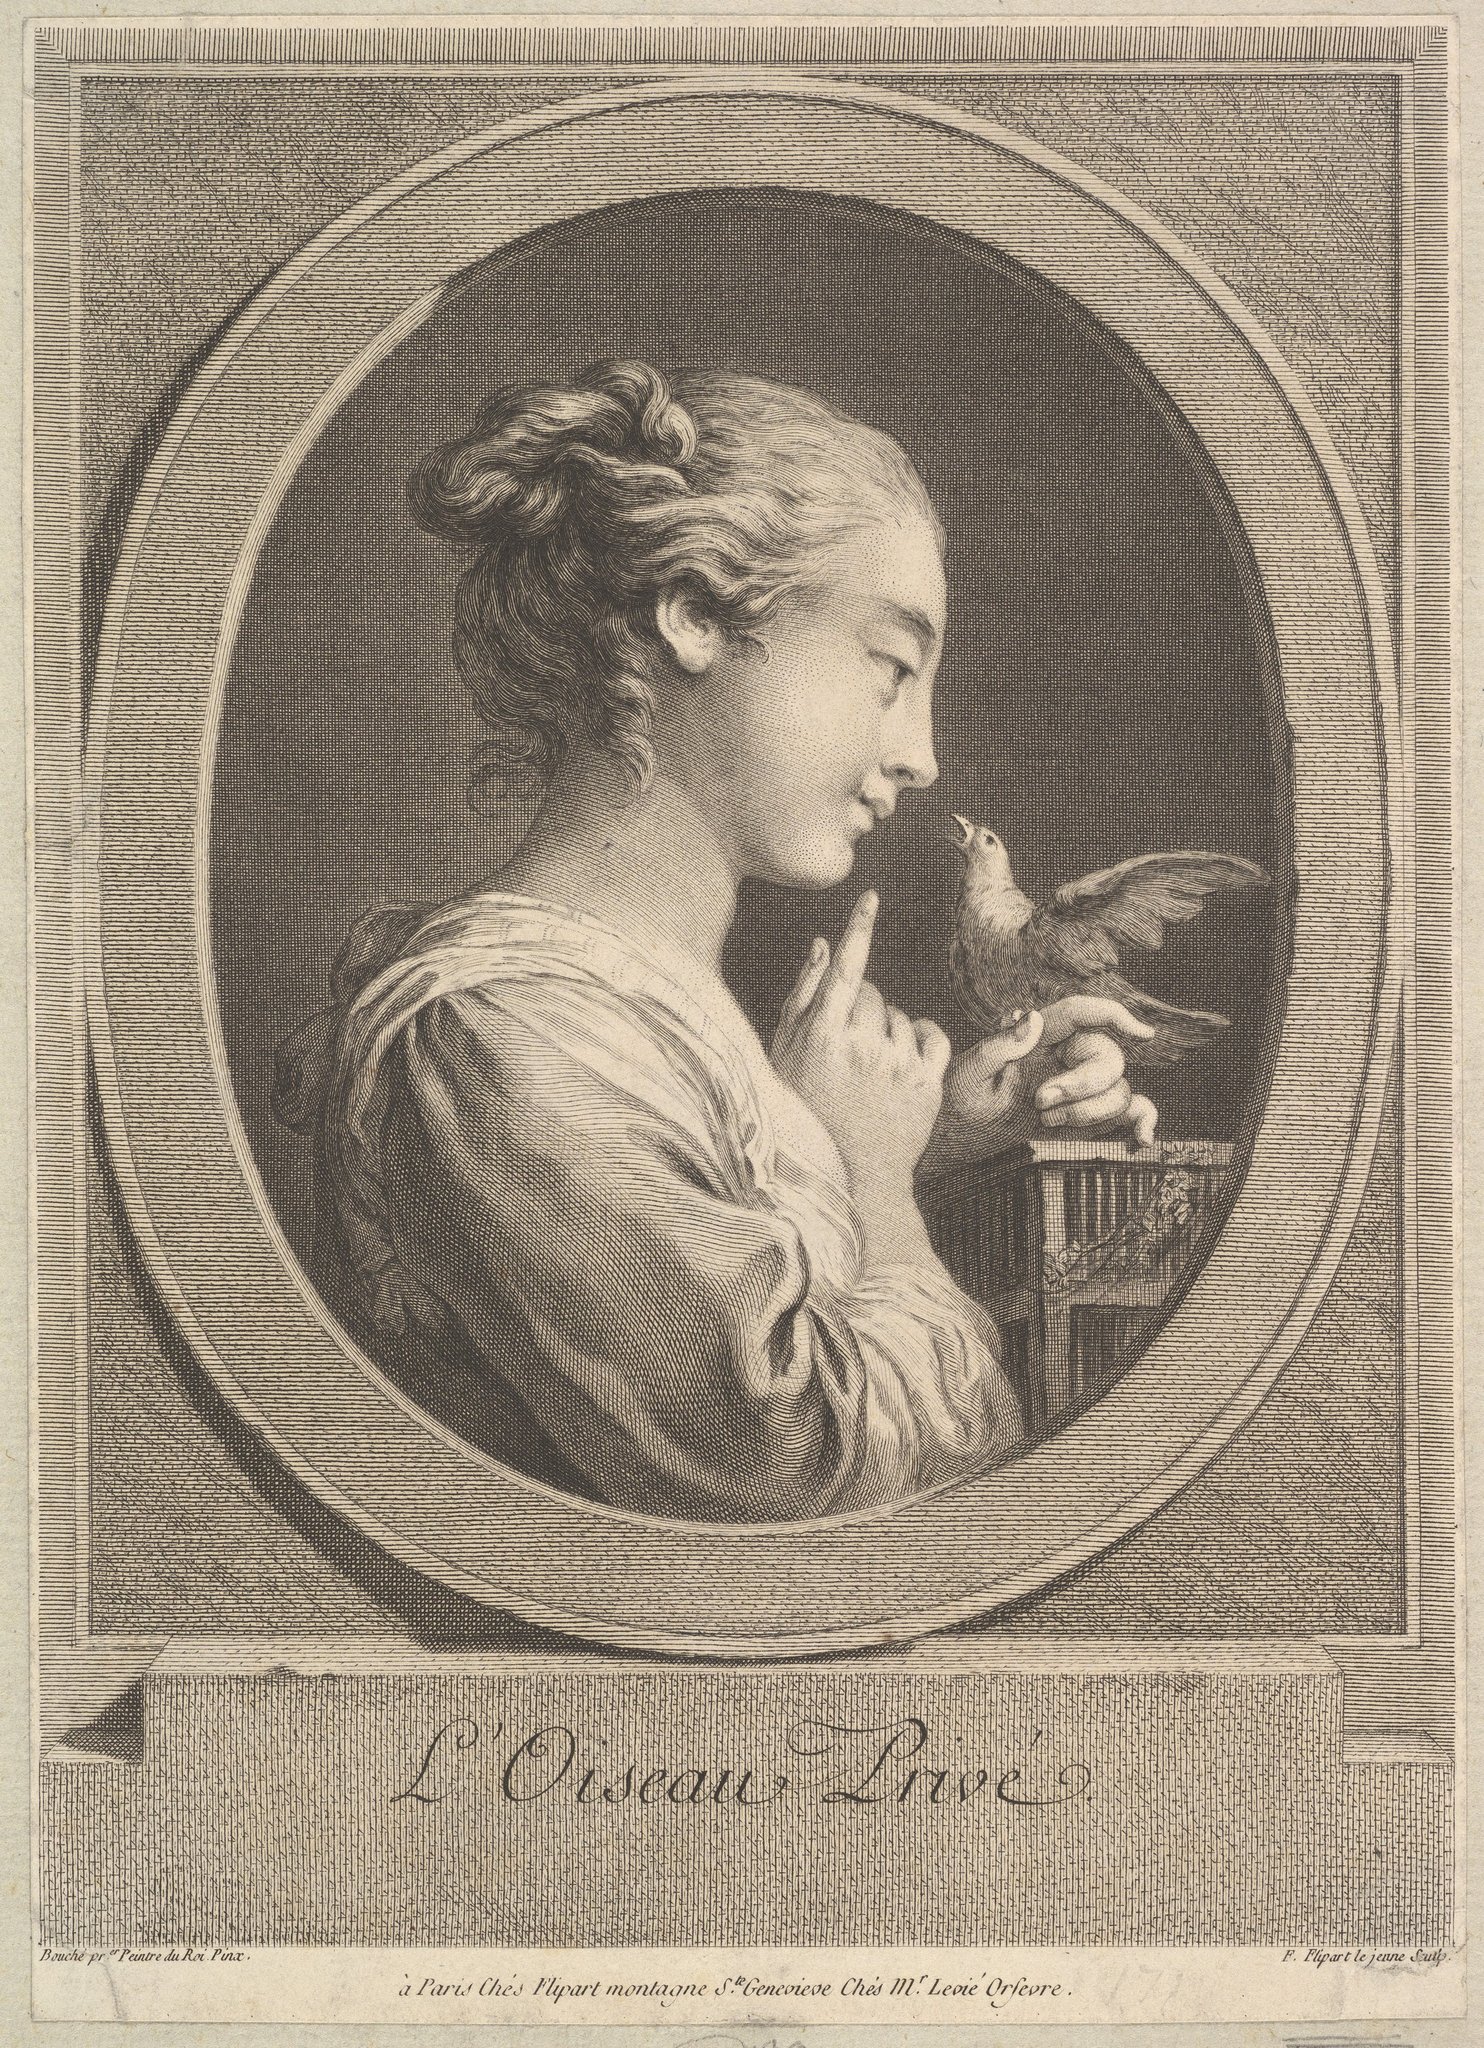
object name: print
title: The Tamed Bird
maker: jean jacques flipart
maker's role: artist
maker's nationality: french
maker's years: 1719-1782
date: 1769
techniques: engraving, etching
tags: birds,women